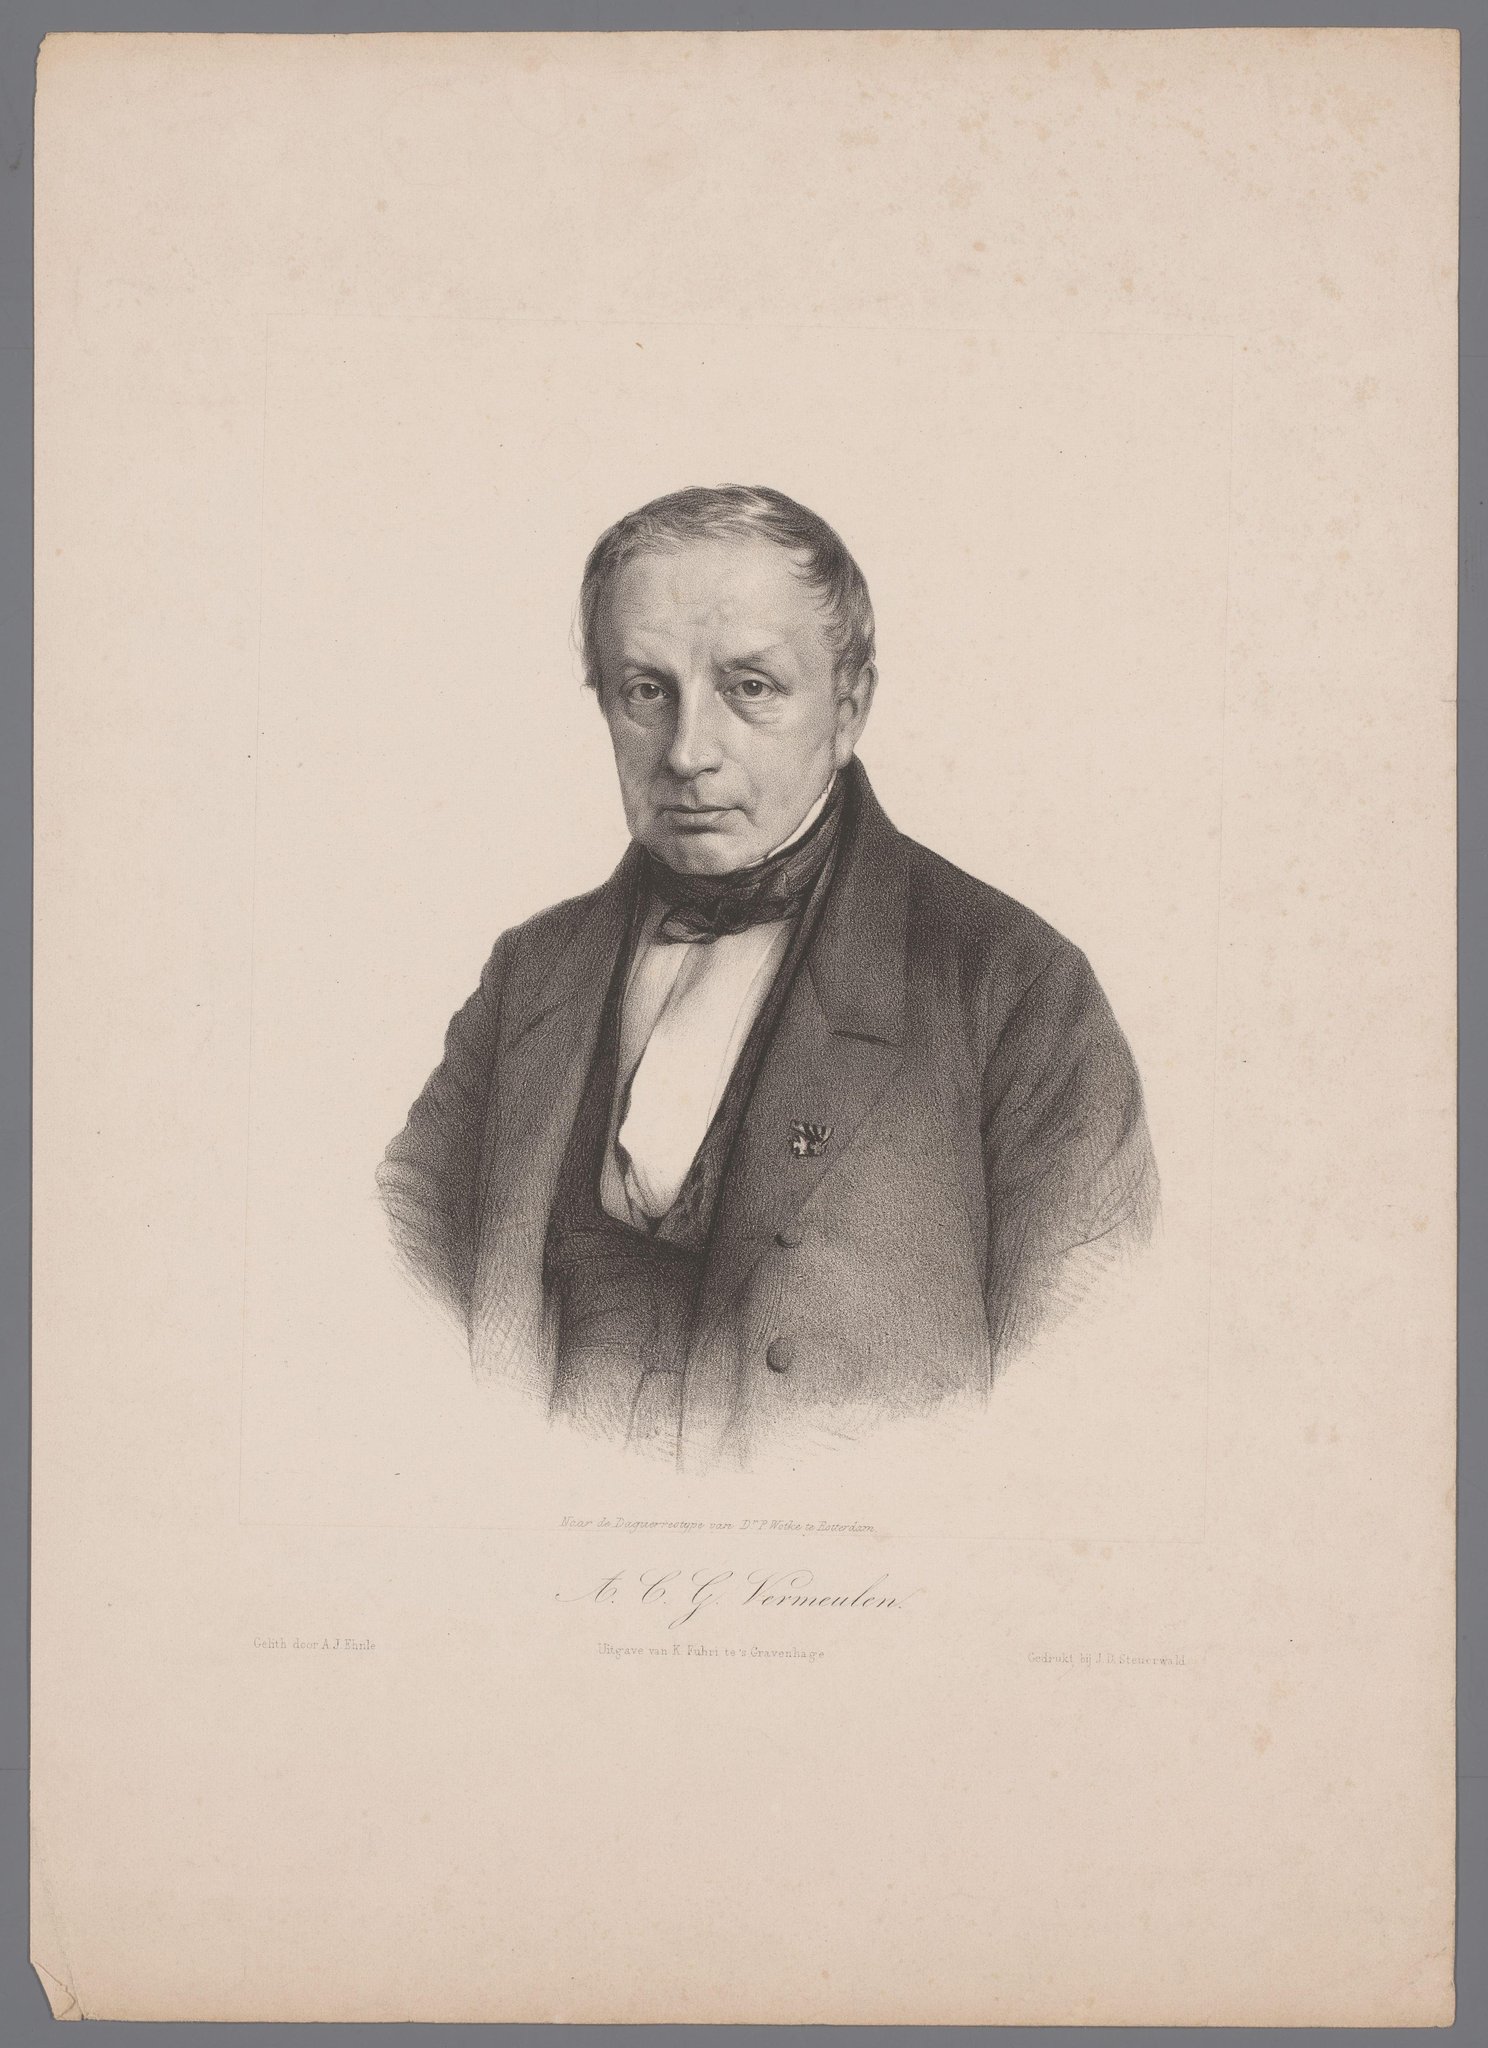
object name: print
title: De Maatschappij ter Bevordering van Toonkunst, haar Muziekfeest en de stad Rotterdam. herinnering aan het jaar 1854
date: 1855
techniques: lithograph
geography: netherlands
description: Portret van Adrianus Catharinus Gerardus Vermeulen, 1854. Onderdeel van een serie van twaalf portretten naar daguerrotypieën en twaalf stadsgezichten. Ter gelegenheid van het Muziekfeest ter viering van het 25-jarige bestaan van de Maatschappij ter Bevordering van Toonkunst in Rotterdam, 12-15 juli 1854.